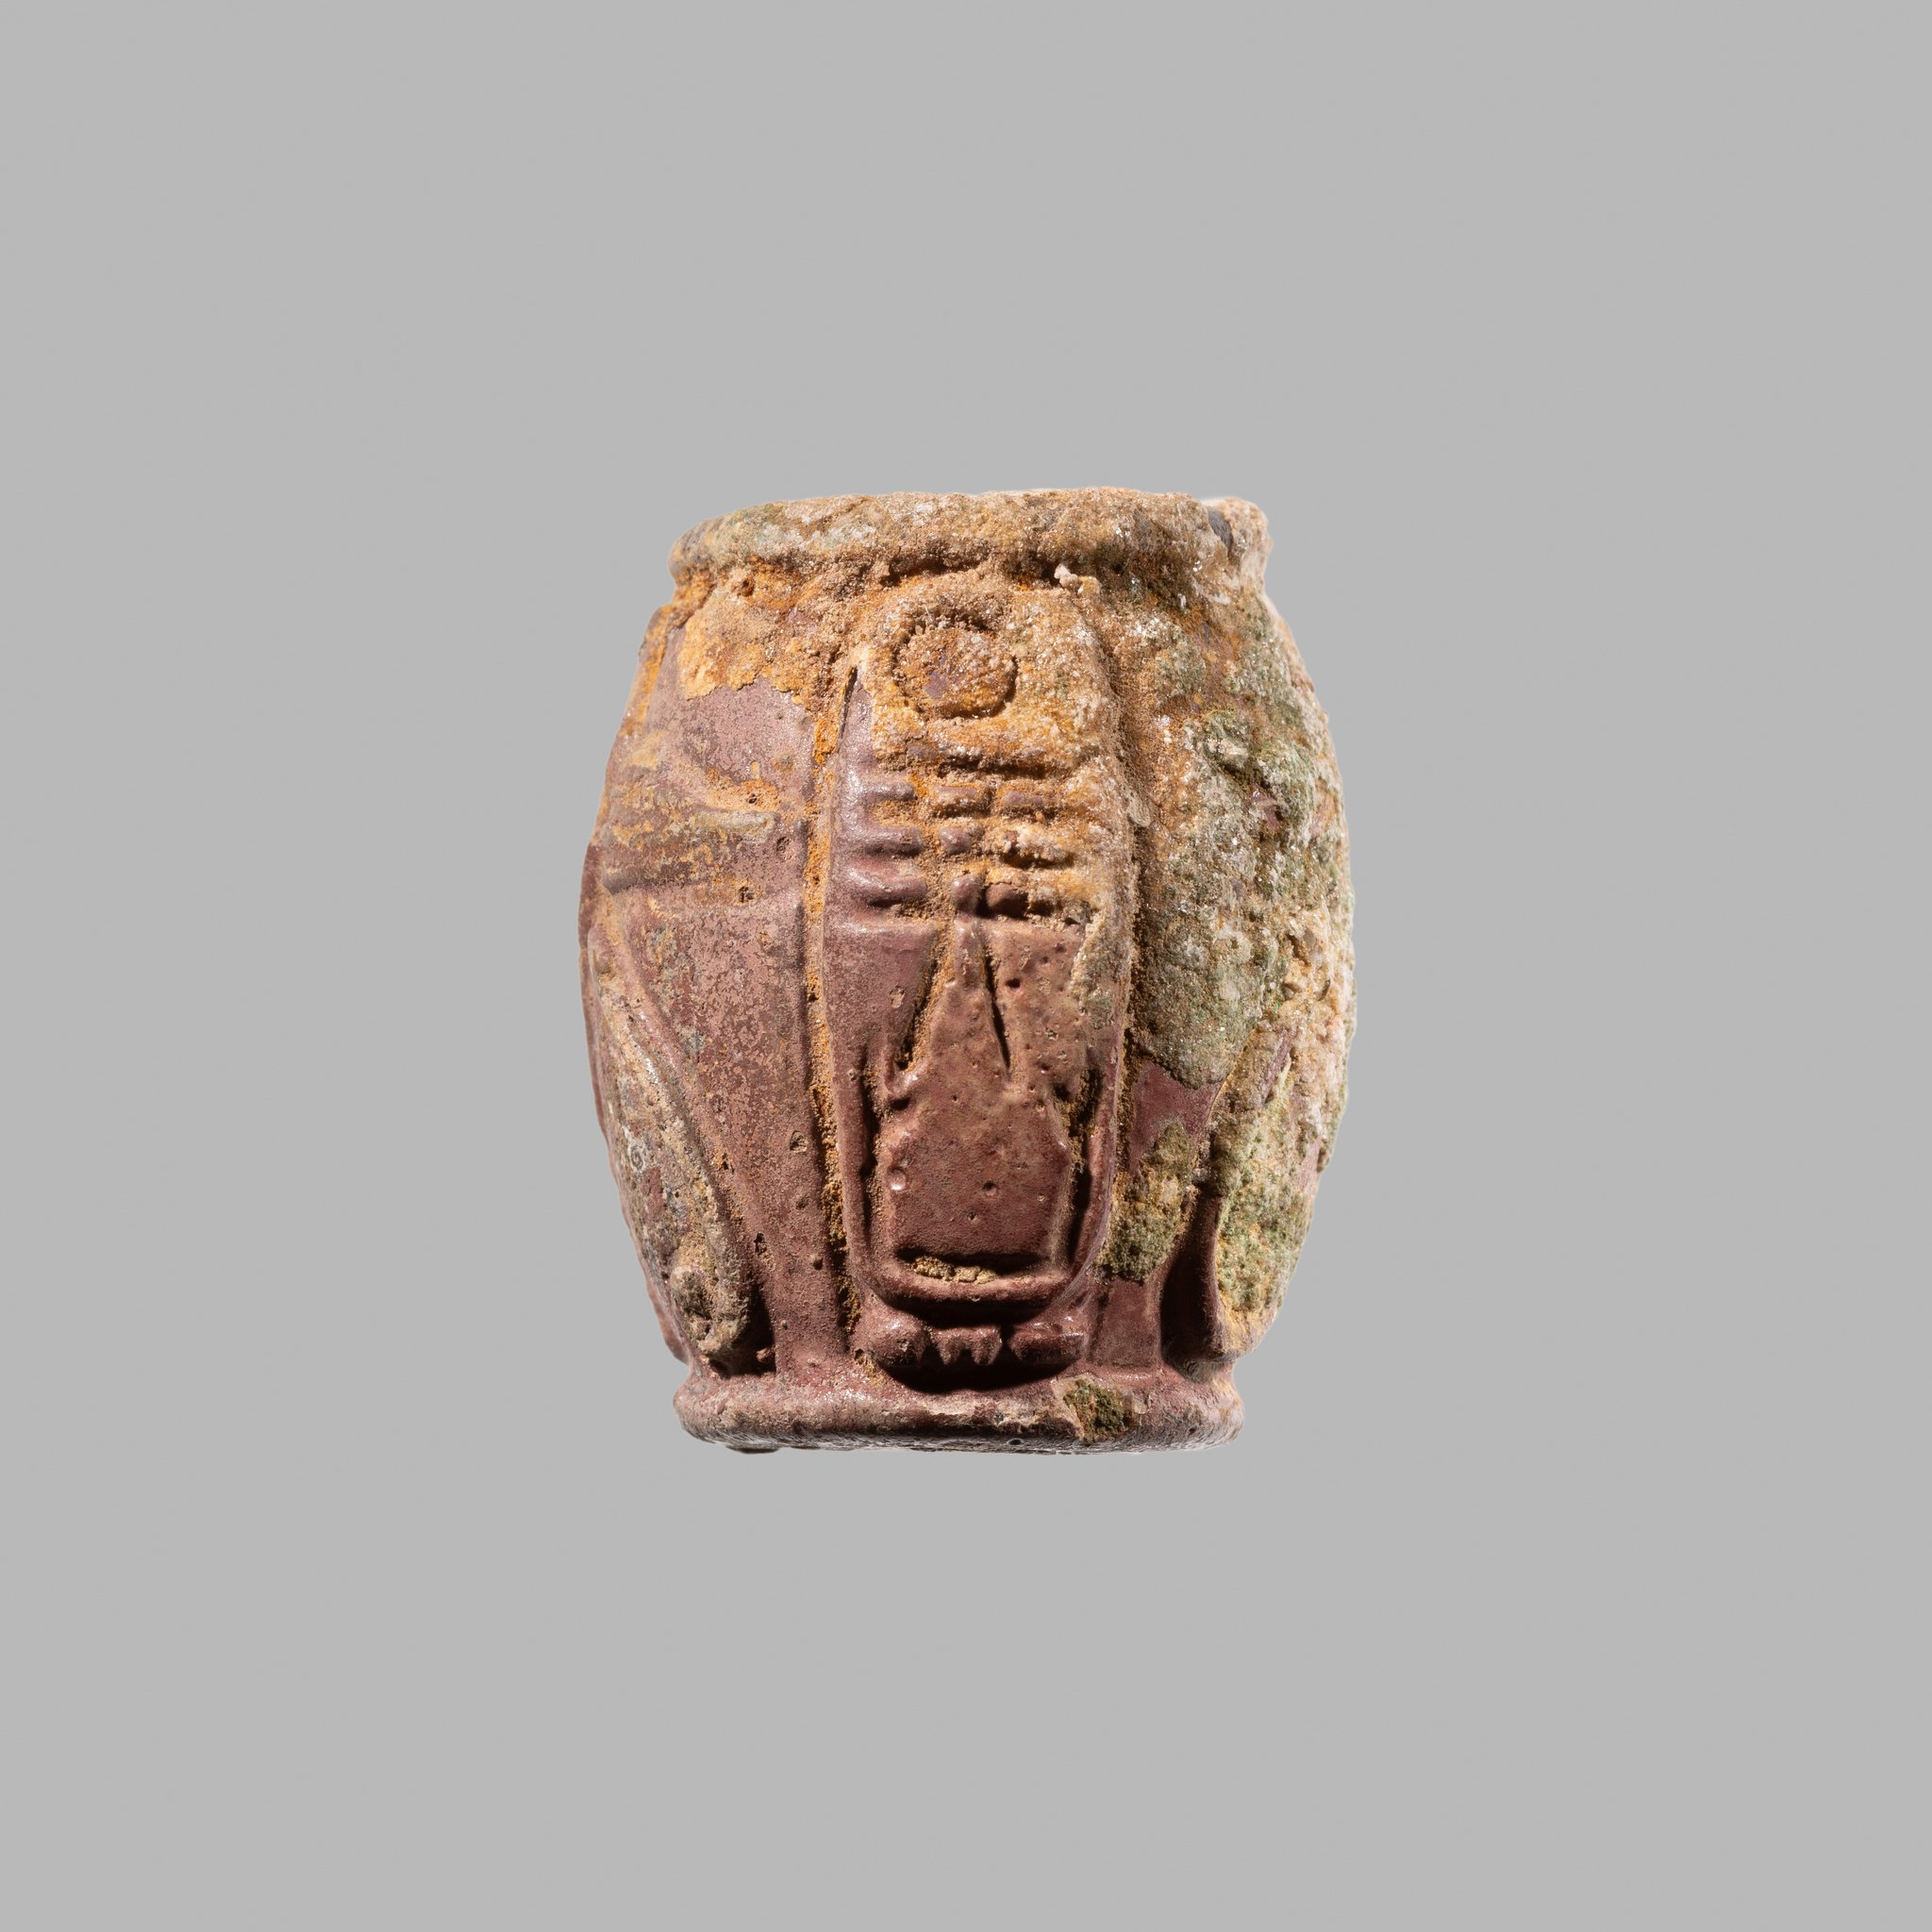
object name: bead, shebitqo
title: Bead with Cartouche of Shebitqo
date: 707-690 BCE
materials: faience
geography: nubia